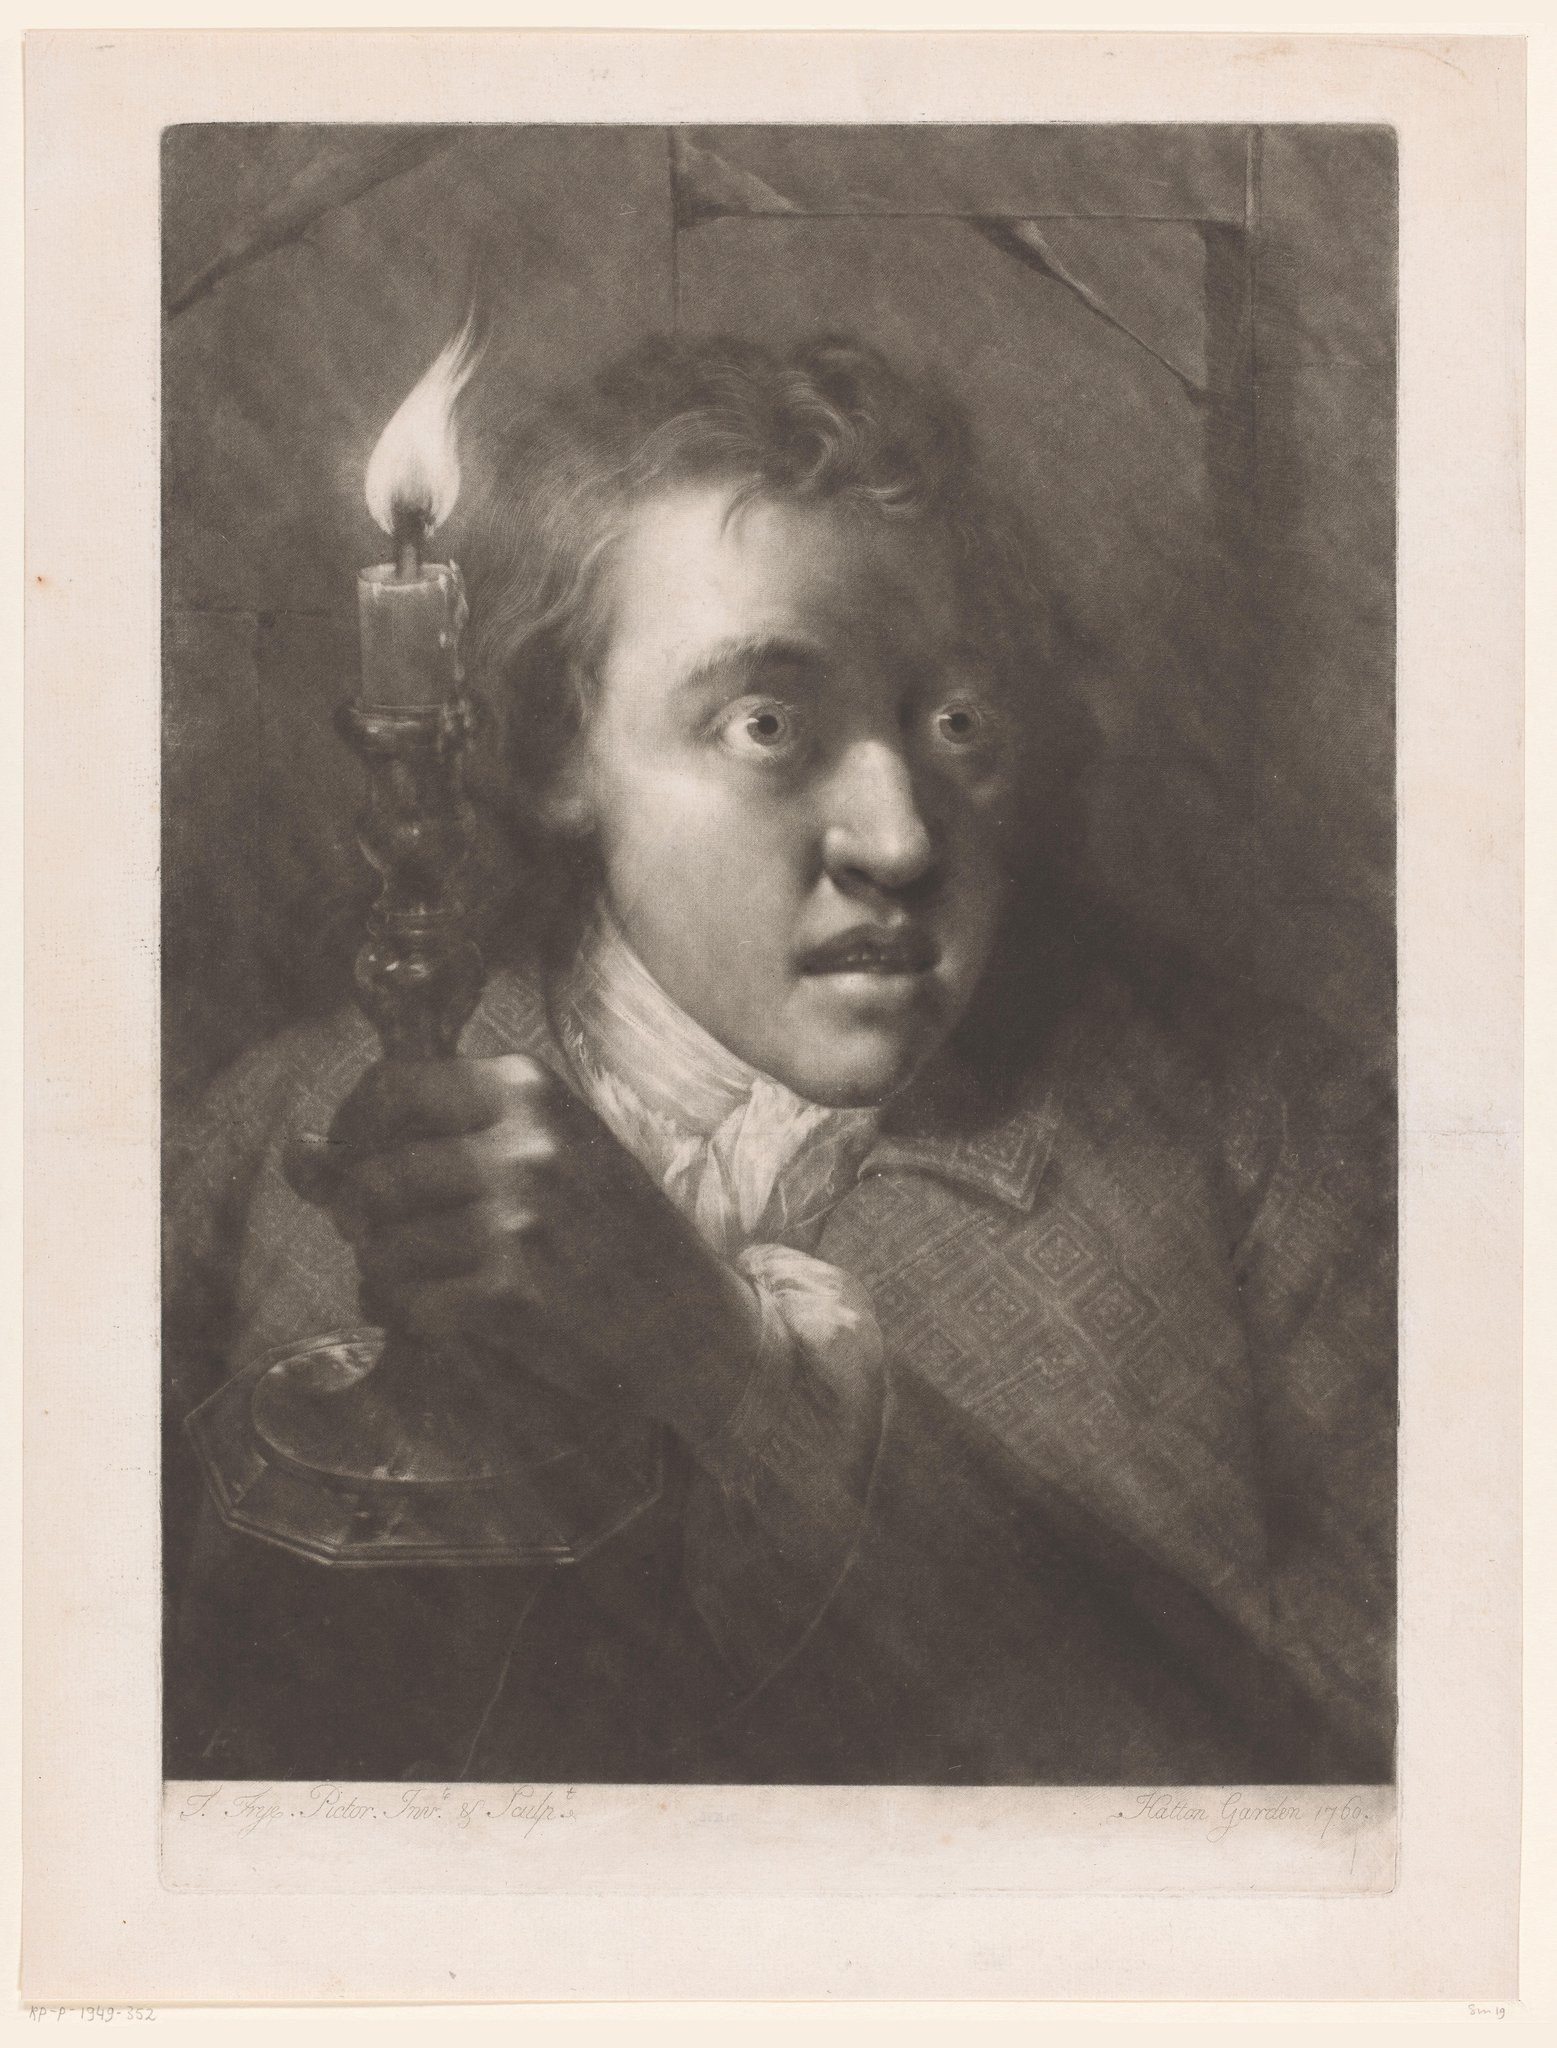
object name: print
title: Life-sized Heads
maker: thomas frye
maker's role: print maker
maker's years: 1710-1762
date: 1760-1762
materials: paper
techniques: mezzotint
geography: london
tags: passions, emotions, affections, lifted eyebrows, candle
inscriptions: collector's mark: Lugt 2228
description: Frye voerde portretten uit in olieverf, pastel en mezzotint. Deze prent is deel van een serie van achttien levensgrote koppen met verschillende uitdrukkingen en in verschillende houdingen, uitgegeven tussen 1760-1762.